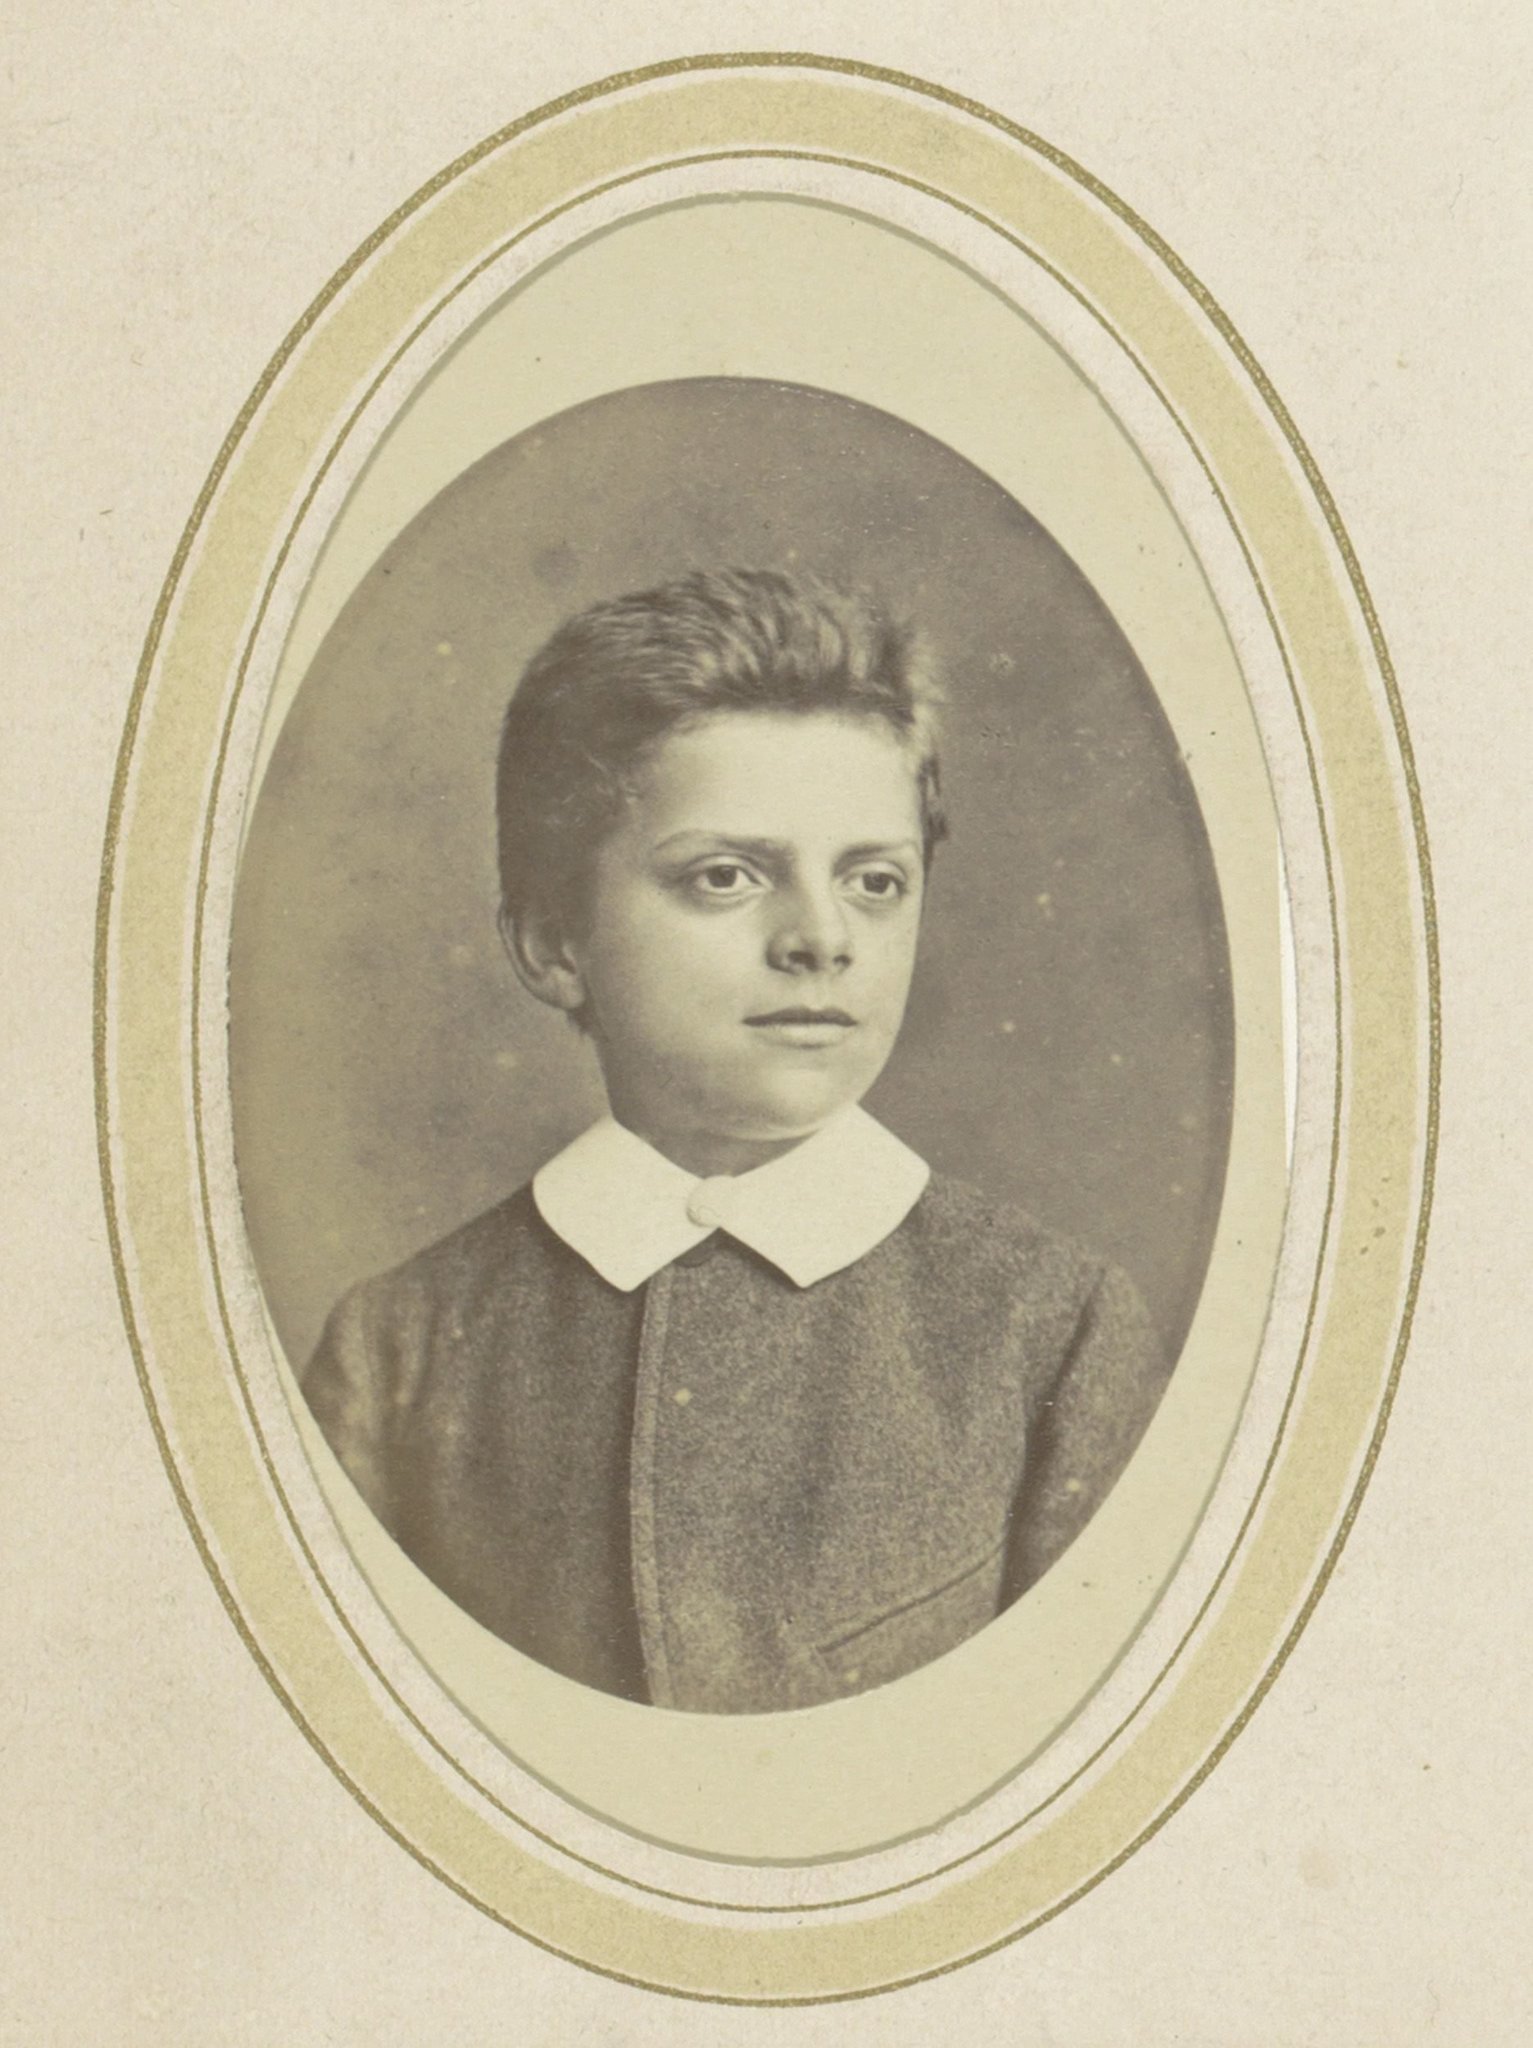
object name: carte de visite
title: Portret van een jongen met een witte kraag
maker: johan christiaan reesinck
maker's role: fotograaf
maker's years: 1838-1922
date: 1866-1900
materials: cardboard, paper, photographic support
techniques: albumen print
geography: zutphen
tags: historical persons, neck-gear ~ clothing, clothing for the upper part of the body, hairdress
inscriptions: address: ‘Zutphen’, address: ‘Zutphen Hoek Berkelkade en Brugstraat. B 313.’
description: Onderdeel van Fotoalbum van een Nederlandse familie met 168 cartes-de-visite en kabinetfoto's.